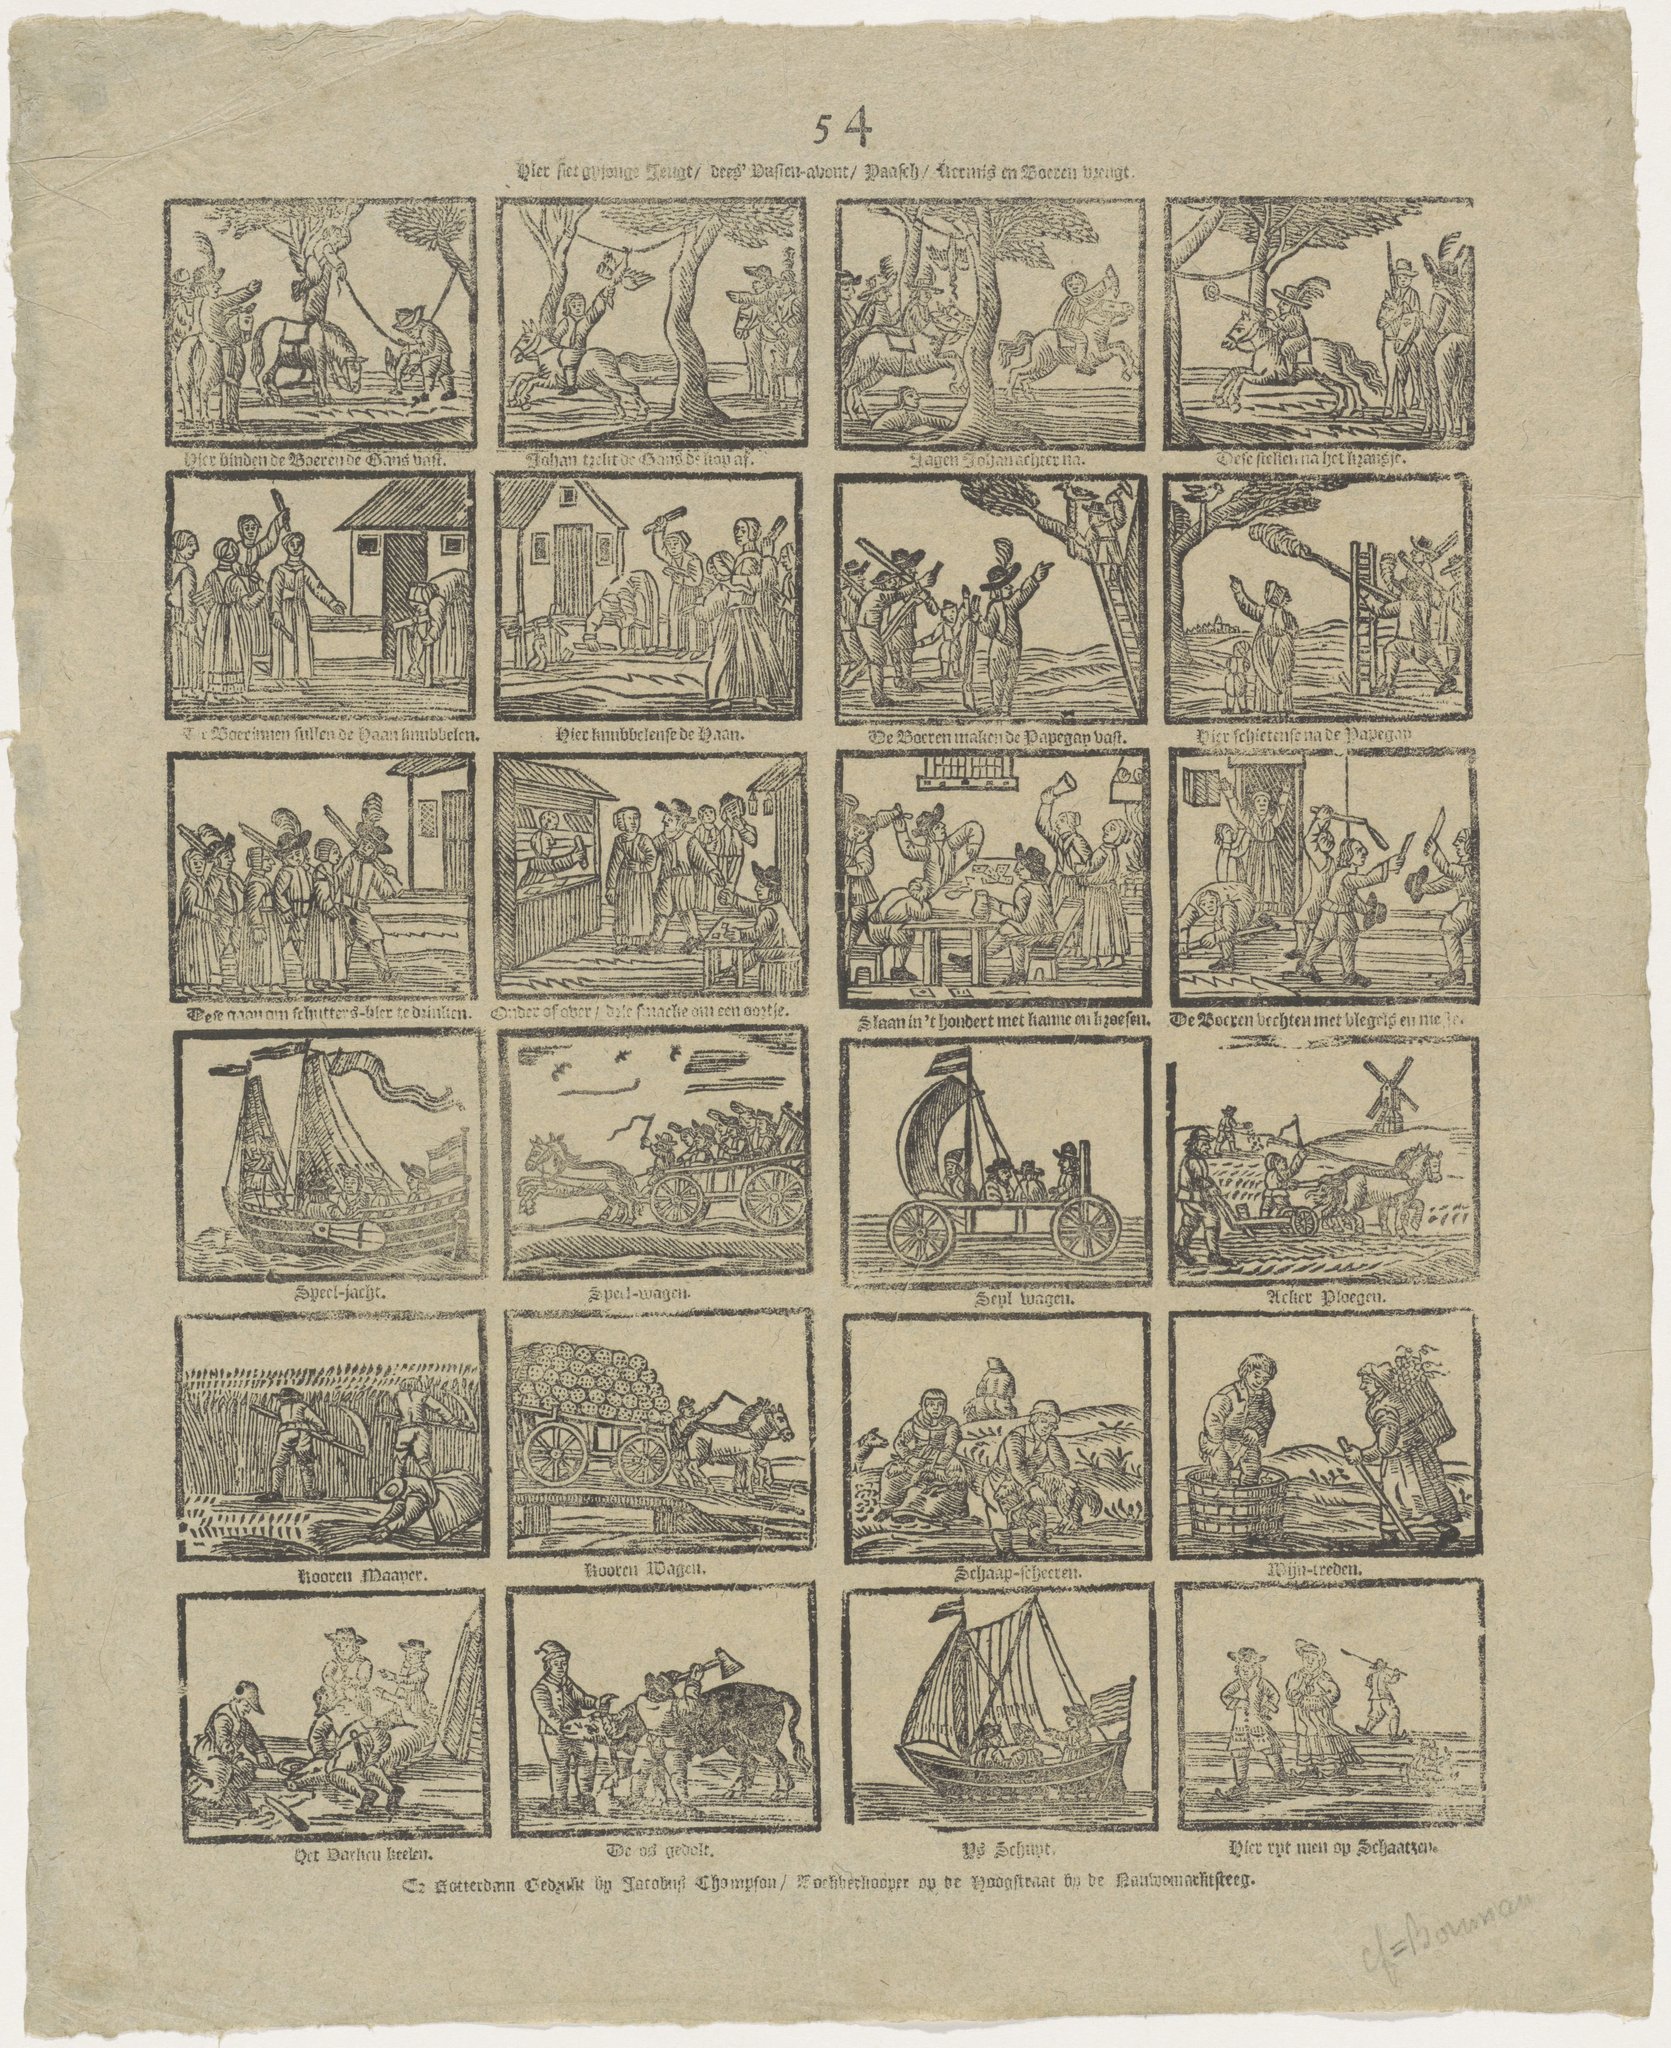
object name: popular print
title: Hier siet gy jonge jeugt / dees' vasten-avont / Paasch / kermis en boerenvreugt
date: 1791-1812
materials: paper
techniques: letterpress printing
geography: rotterdam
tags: farmers, festivities, strife of lent and carnival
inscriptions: collector's mark: Lugt 2760, collector's mark: Lugt 2228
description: Blad met 24 voorstellingen van kermis- en boerentaferelen. Onder elke afbeelding een onderschrift. Genummerd midden boven: 54.